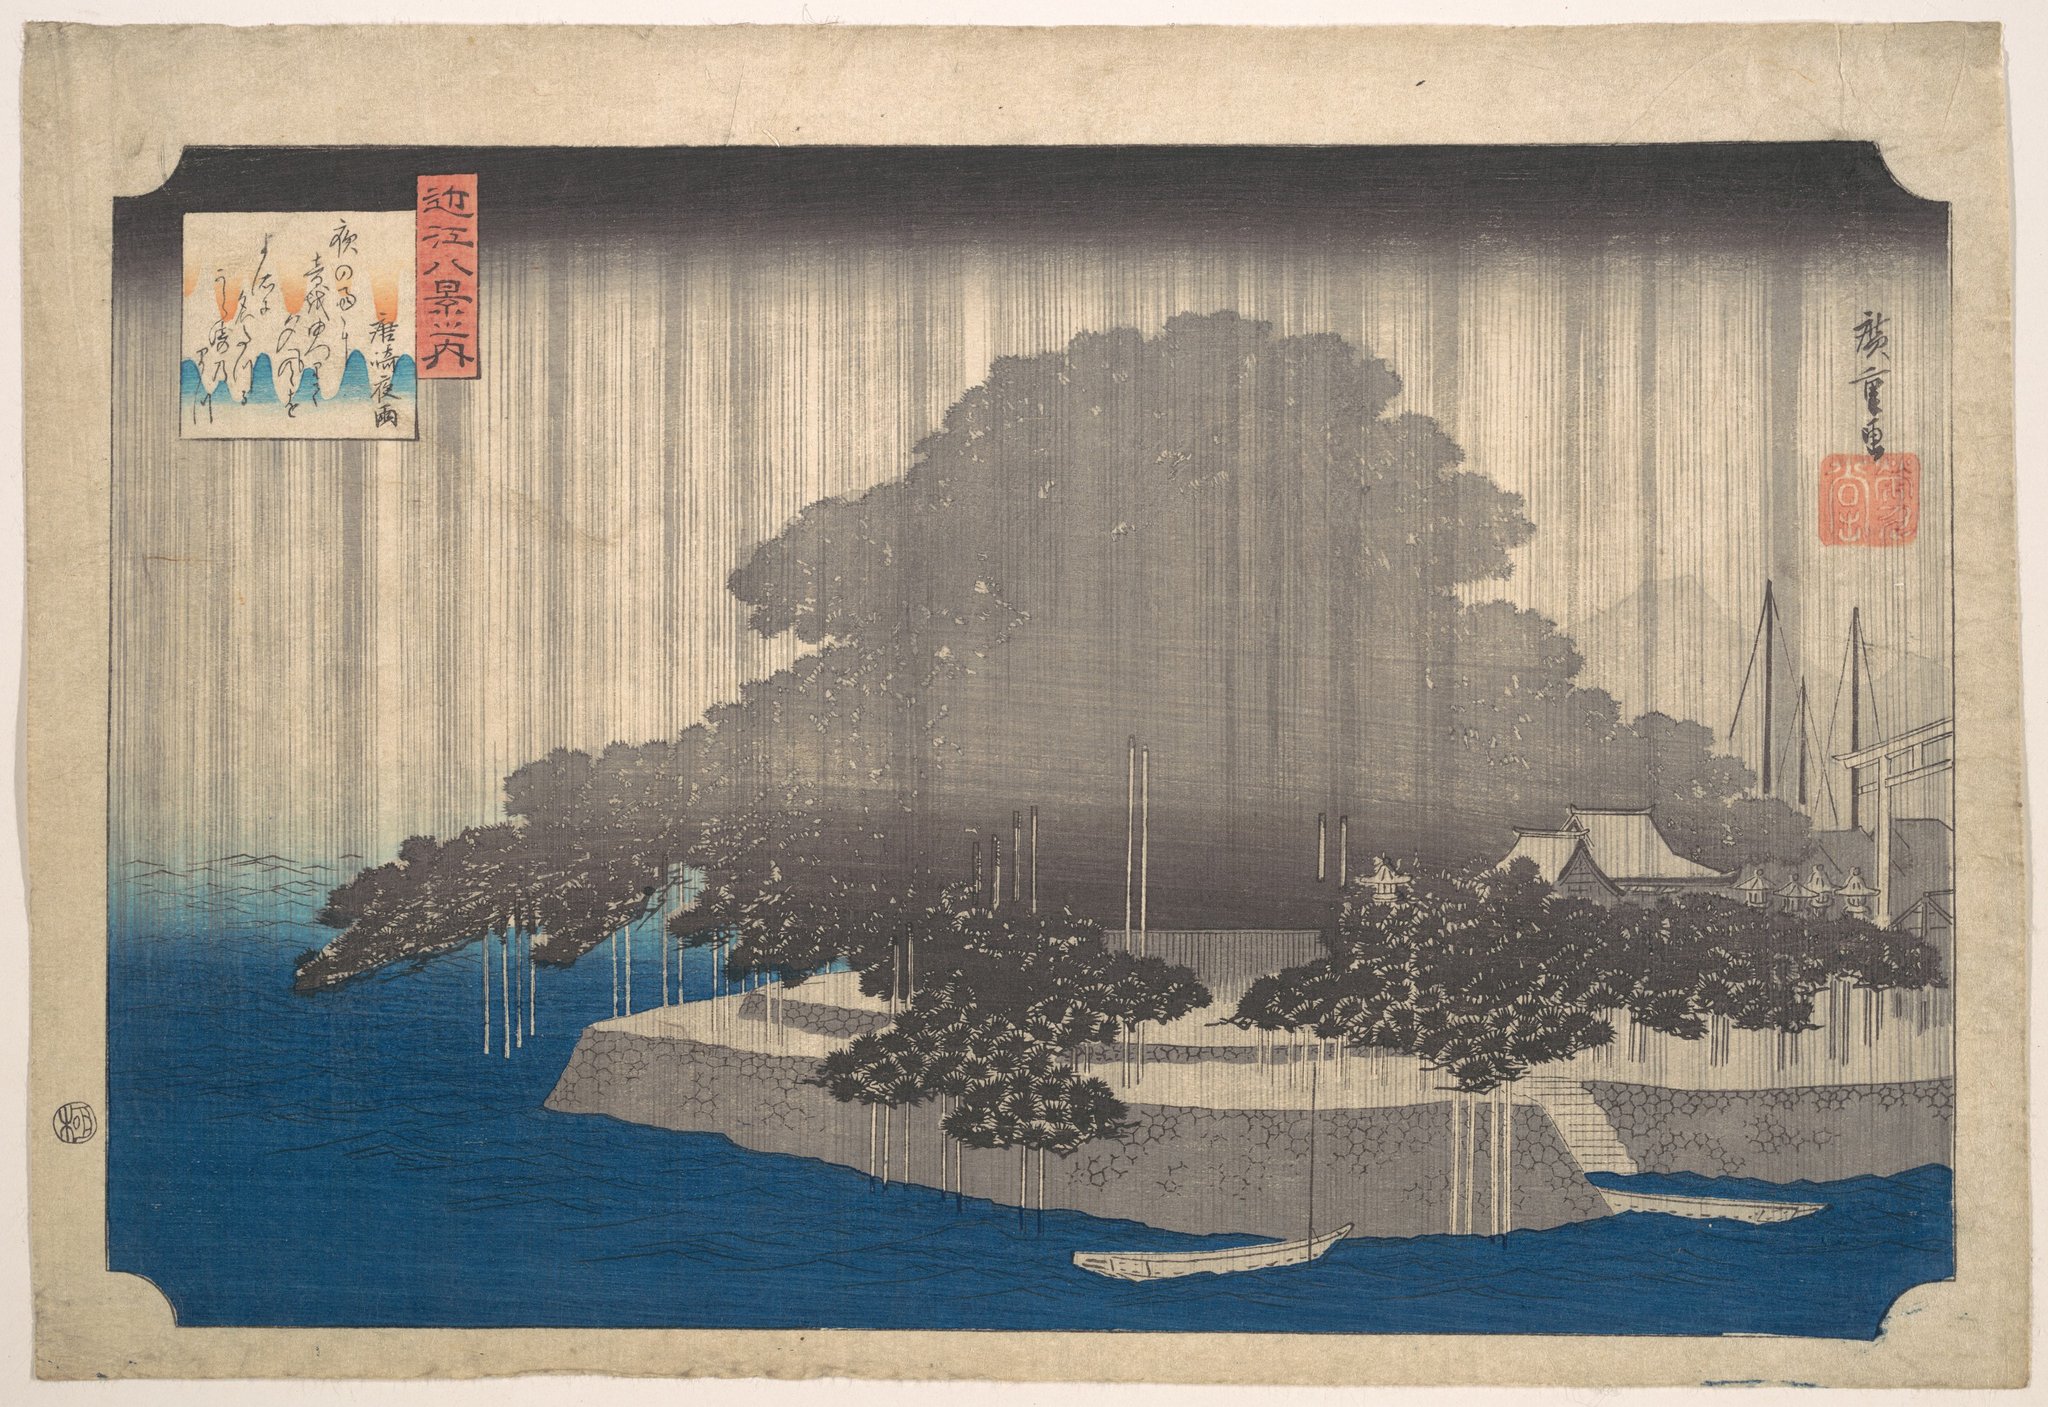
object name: print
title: Evening Rain on the Karasaki Pine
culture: japanese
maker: utagawa hiroshige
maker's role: artist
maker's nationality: japanese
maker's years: 1797-1858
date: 1797-1858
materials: ink, paper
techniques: woodblock print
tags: trees,evening,rain